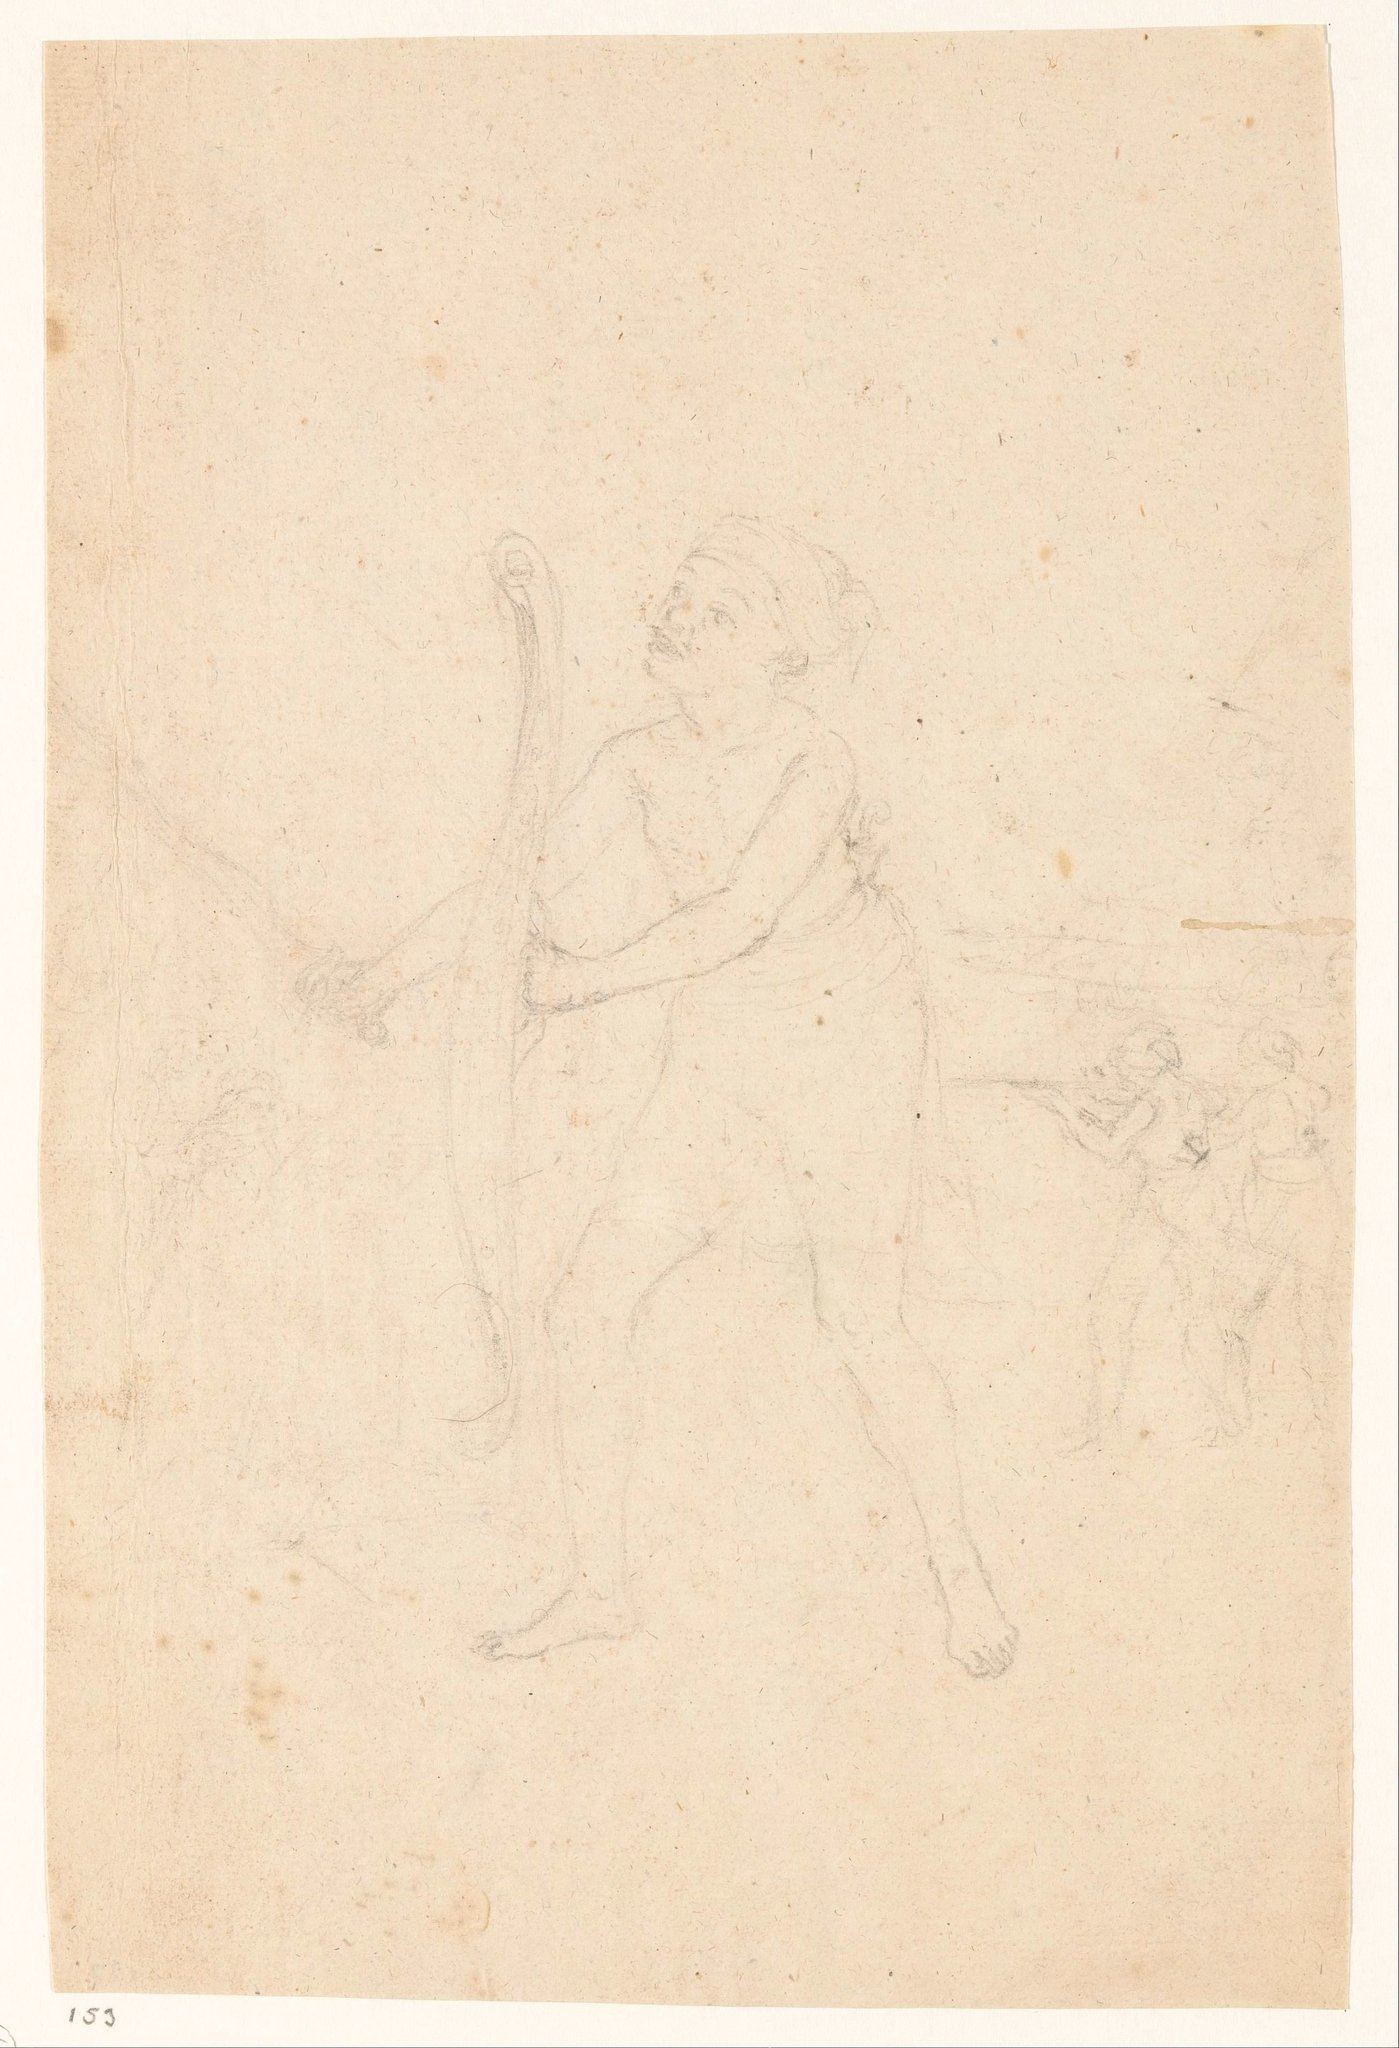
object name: drawing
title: Javaanse krijger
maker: jan brandes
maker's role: draughtsman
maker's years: 1743-1808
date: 1779-1785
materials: paper, pencil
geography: batavia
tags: asiatic races and peoples (indonesians), the soldier; the soldier's life, java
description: Javaanse krijger met zwaard, schild, en kris op de rug. Op de achtergrond geweerschutters.